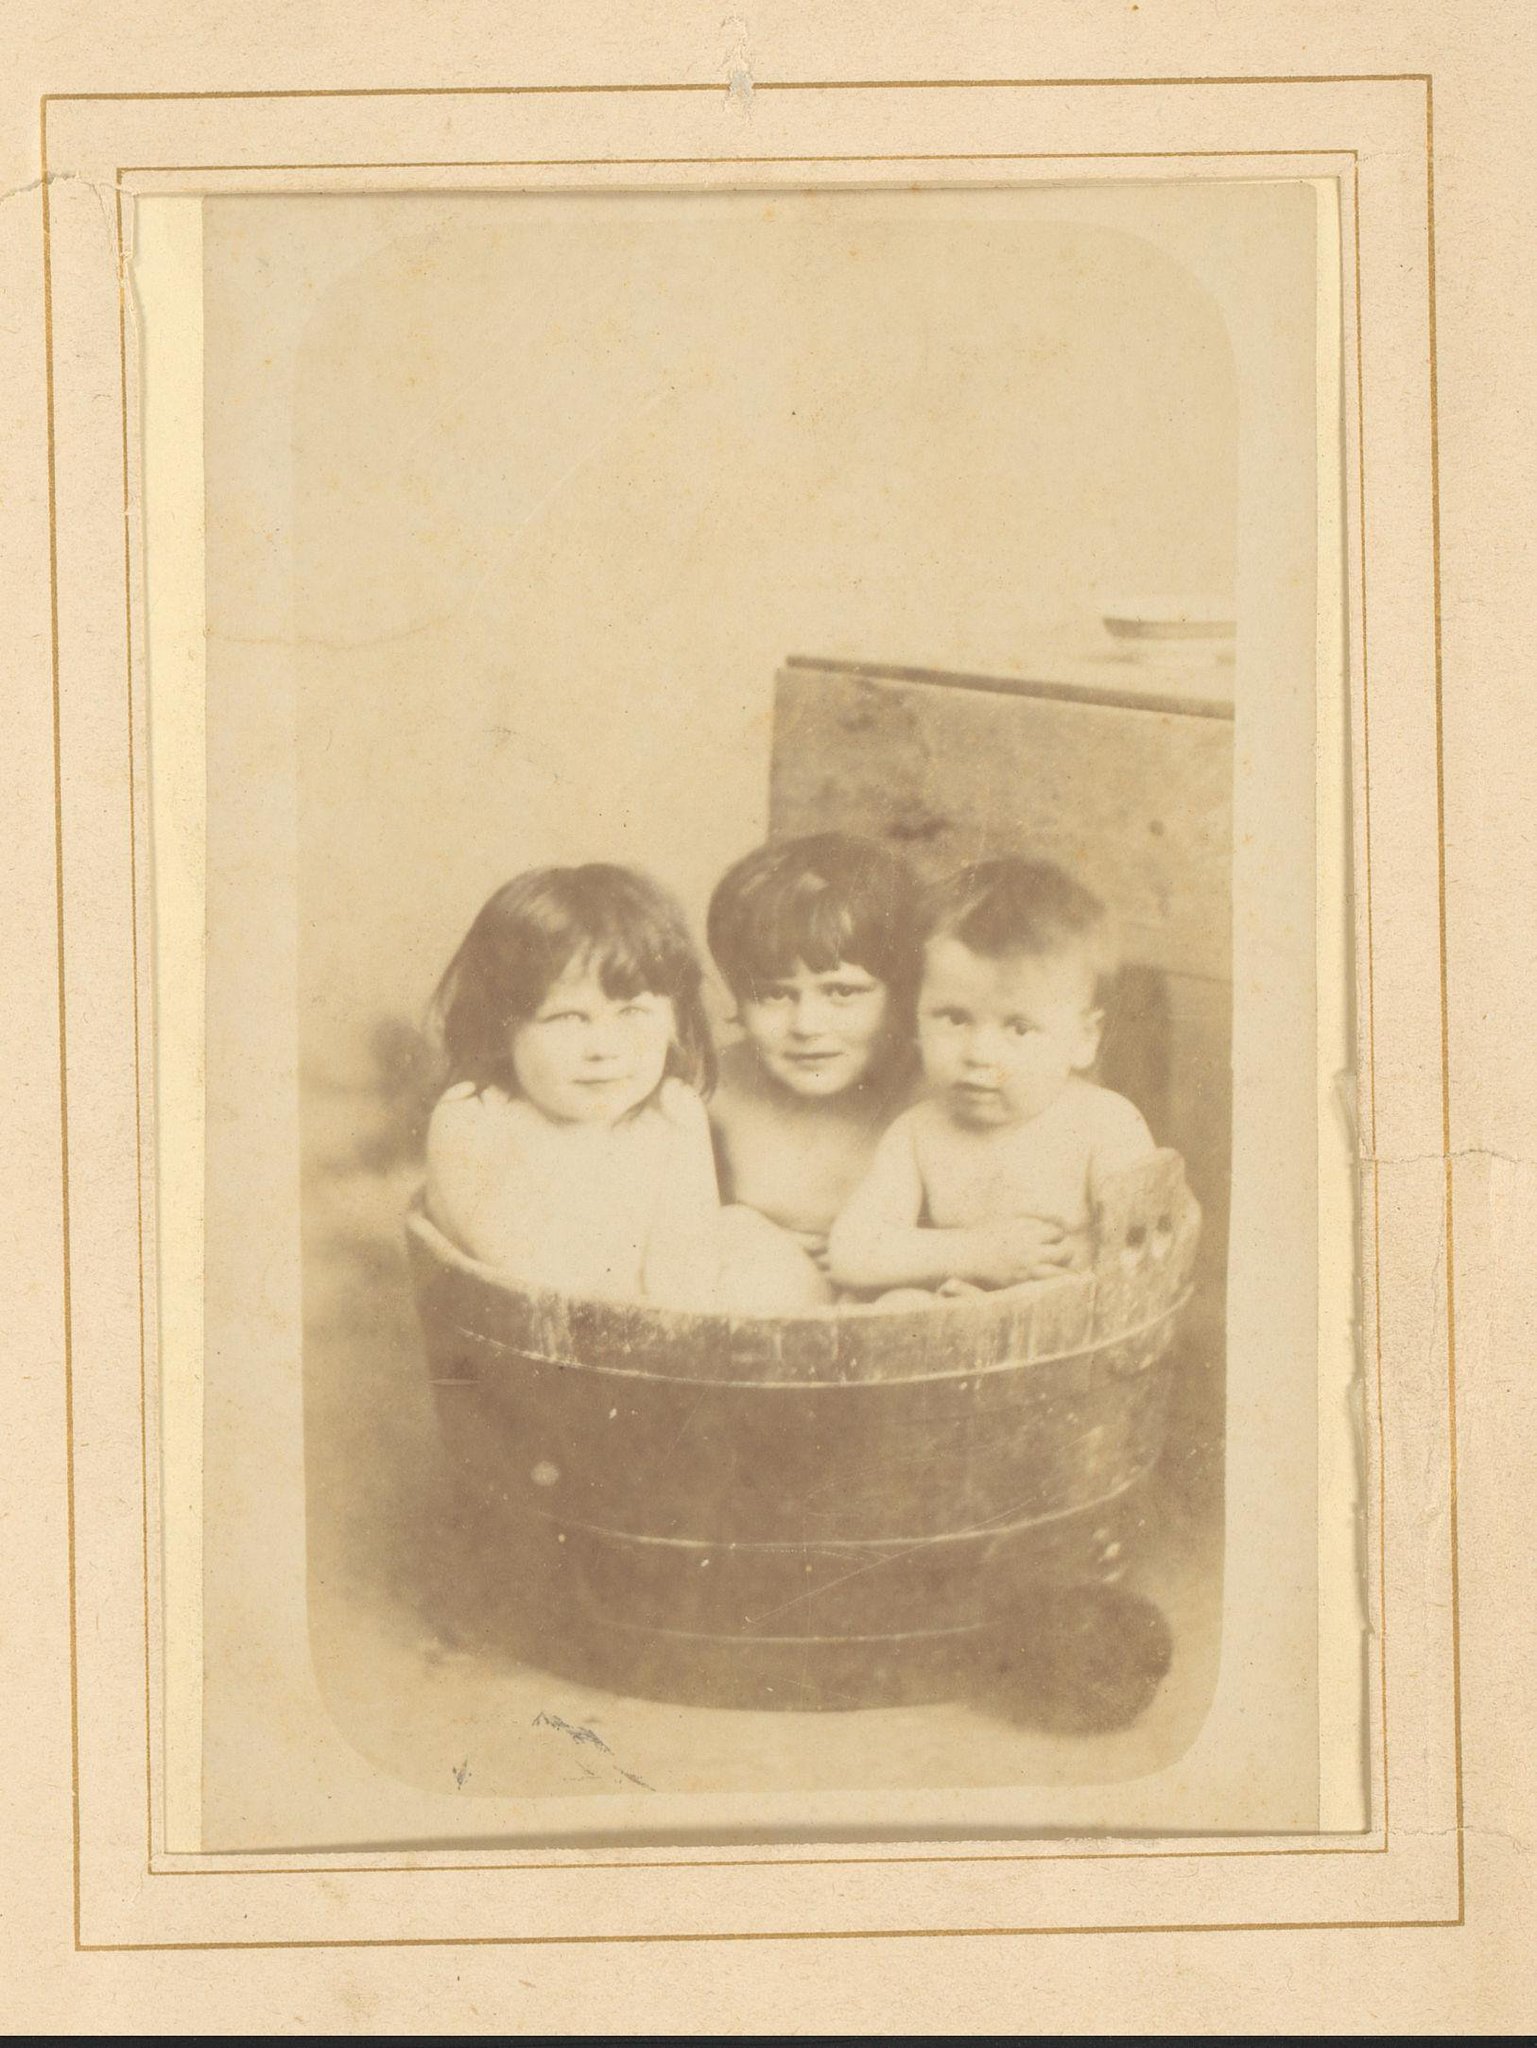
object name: album leaf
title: Drie kinderen in een wastobbe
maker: Anonymous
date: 1850-1900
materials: cardboard, photographic support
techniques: albumen print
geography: england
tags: tub-bath, boy (child between toddler and youth) (+ three persons), anonymous historical persons portrayed in a group, in a group-portrait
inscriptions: inscription: ‘"RUB-A-DUB, DUB,/ THREE MEN IN A TUB."/ Copyright’